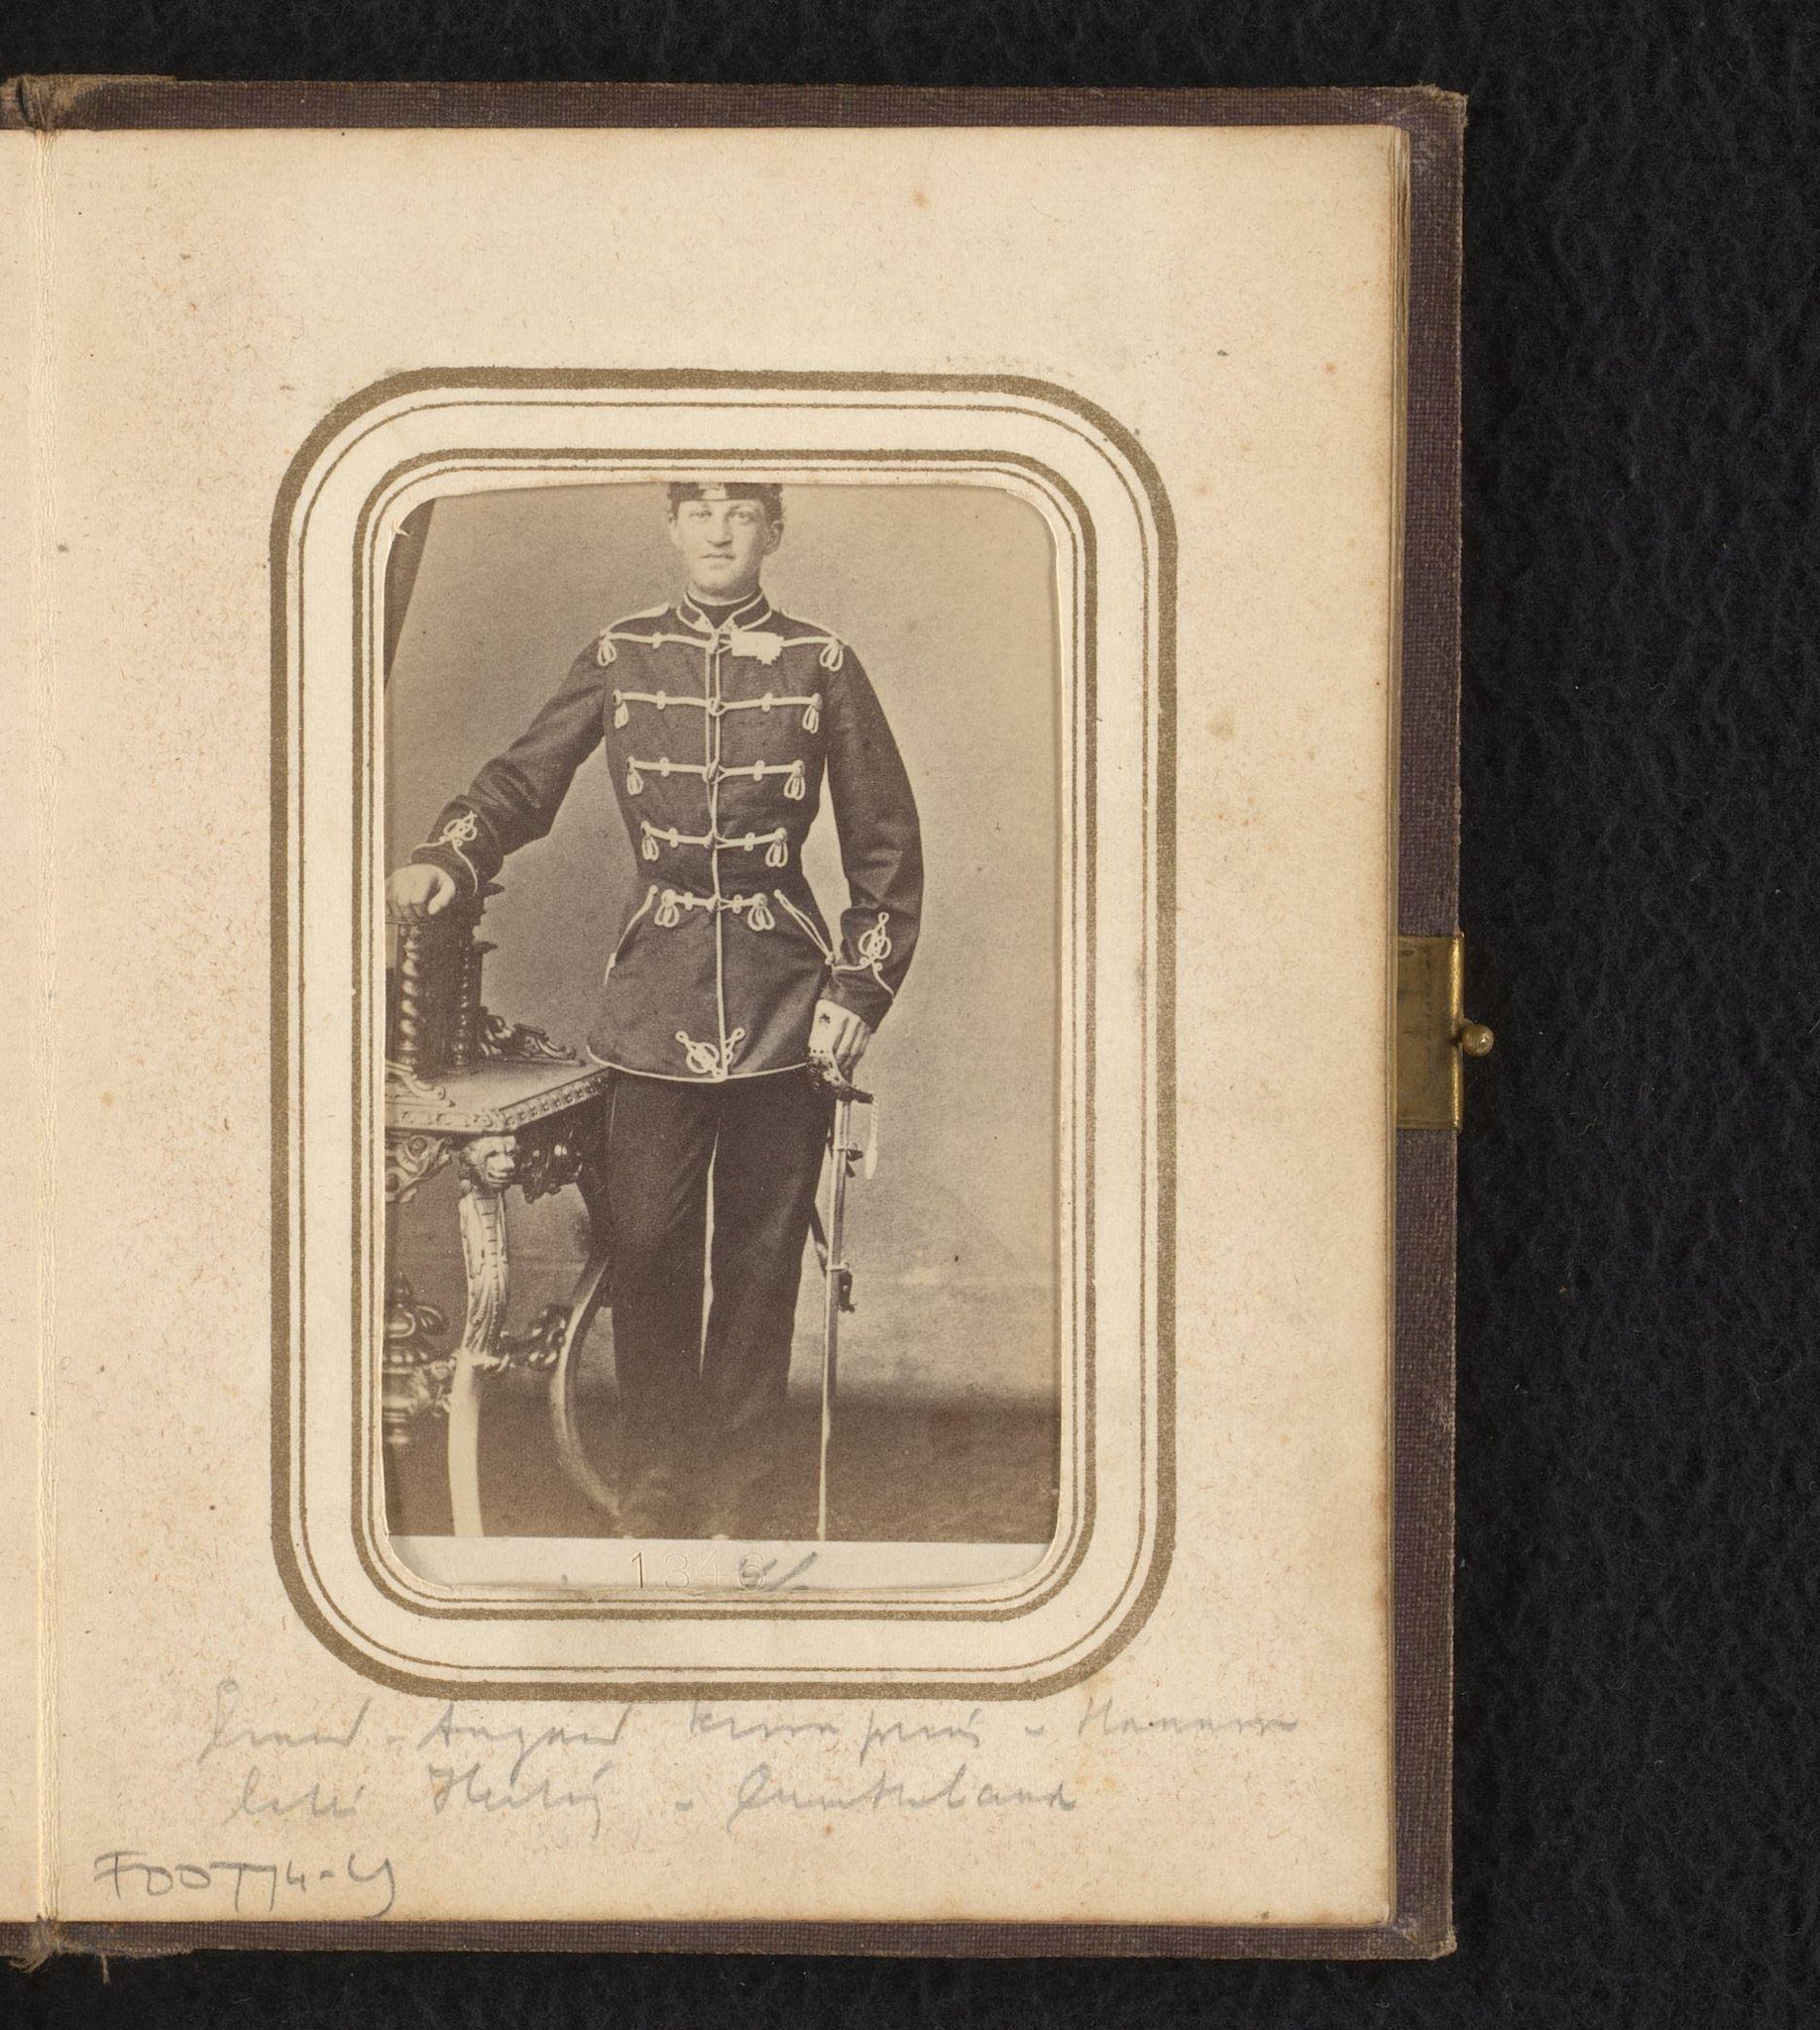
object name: photograph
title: Portret van kroonprins Ernest-August van Hannover in uniform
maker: Anonymous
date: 1860-1875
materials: cardboard, photographic support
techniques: albumen print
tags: historical persons, (military) uniforms, crown prince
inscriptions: name: ‘kronprinz v Hannover’, annotation: ‘Ernest-August kroonprins v Hannover/ later Hertog v Cumberland’, number: ‘1346’